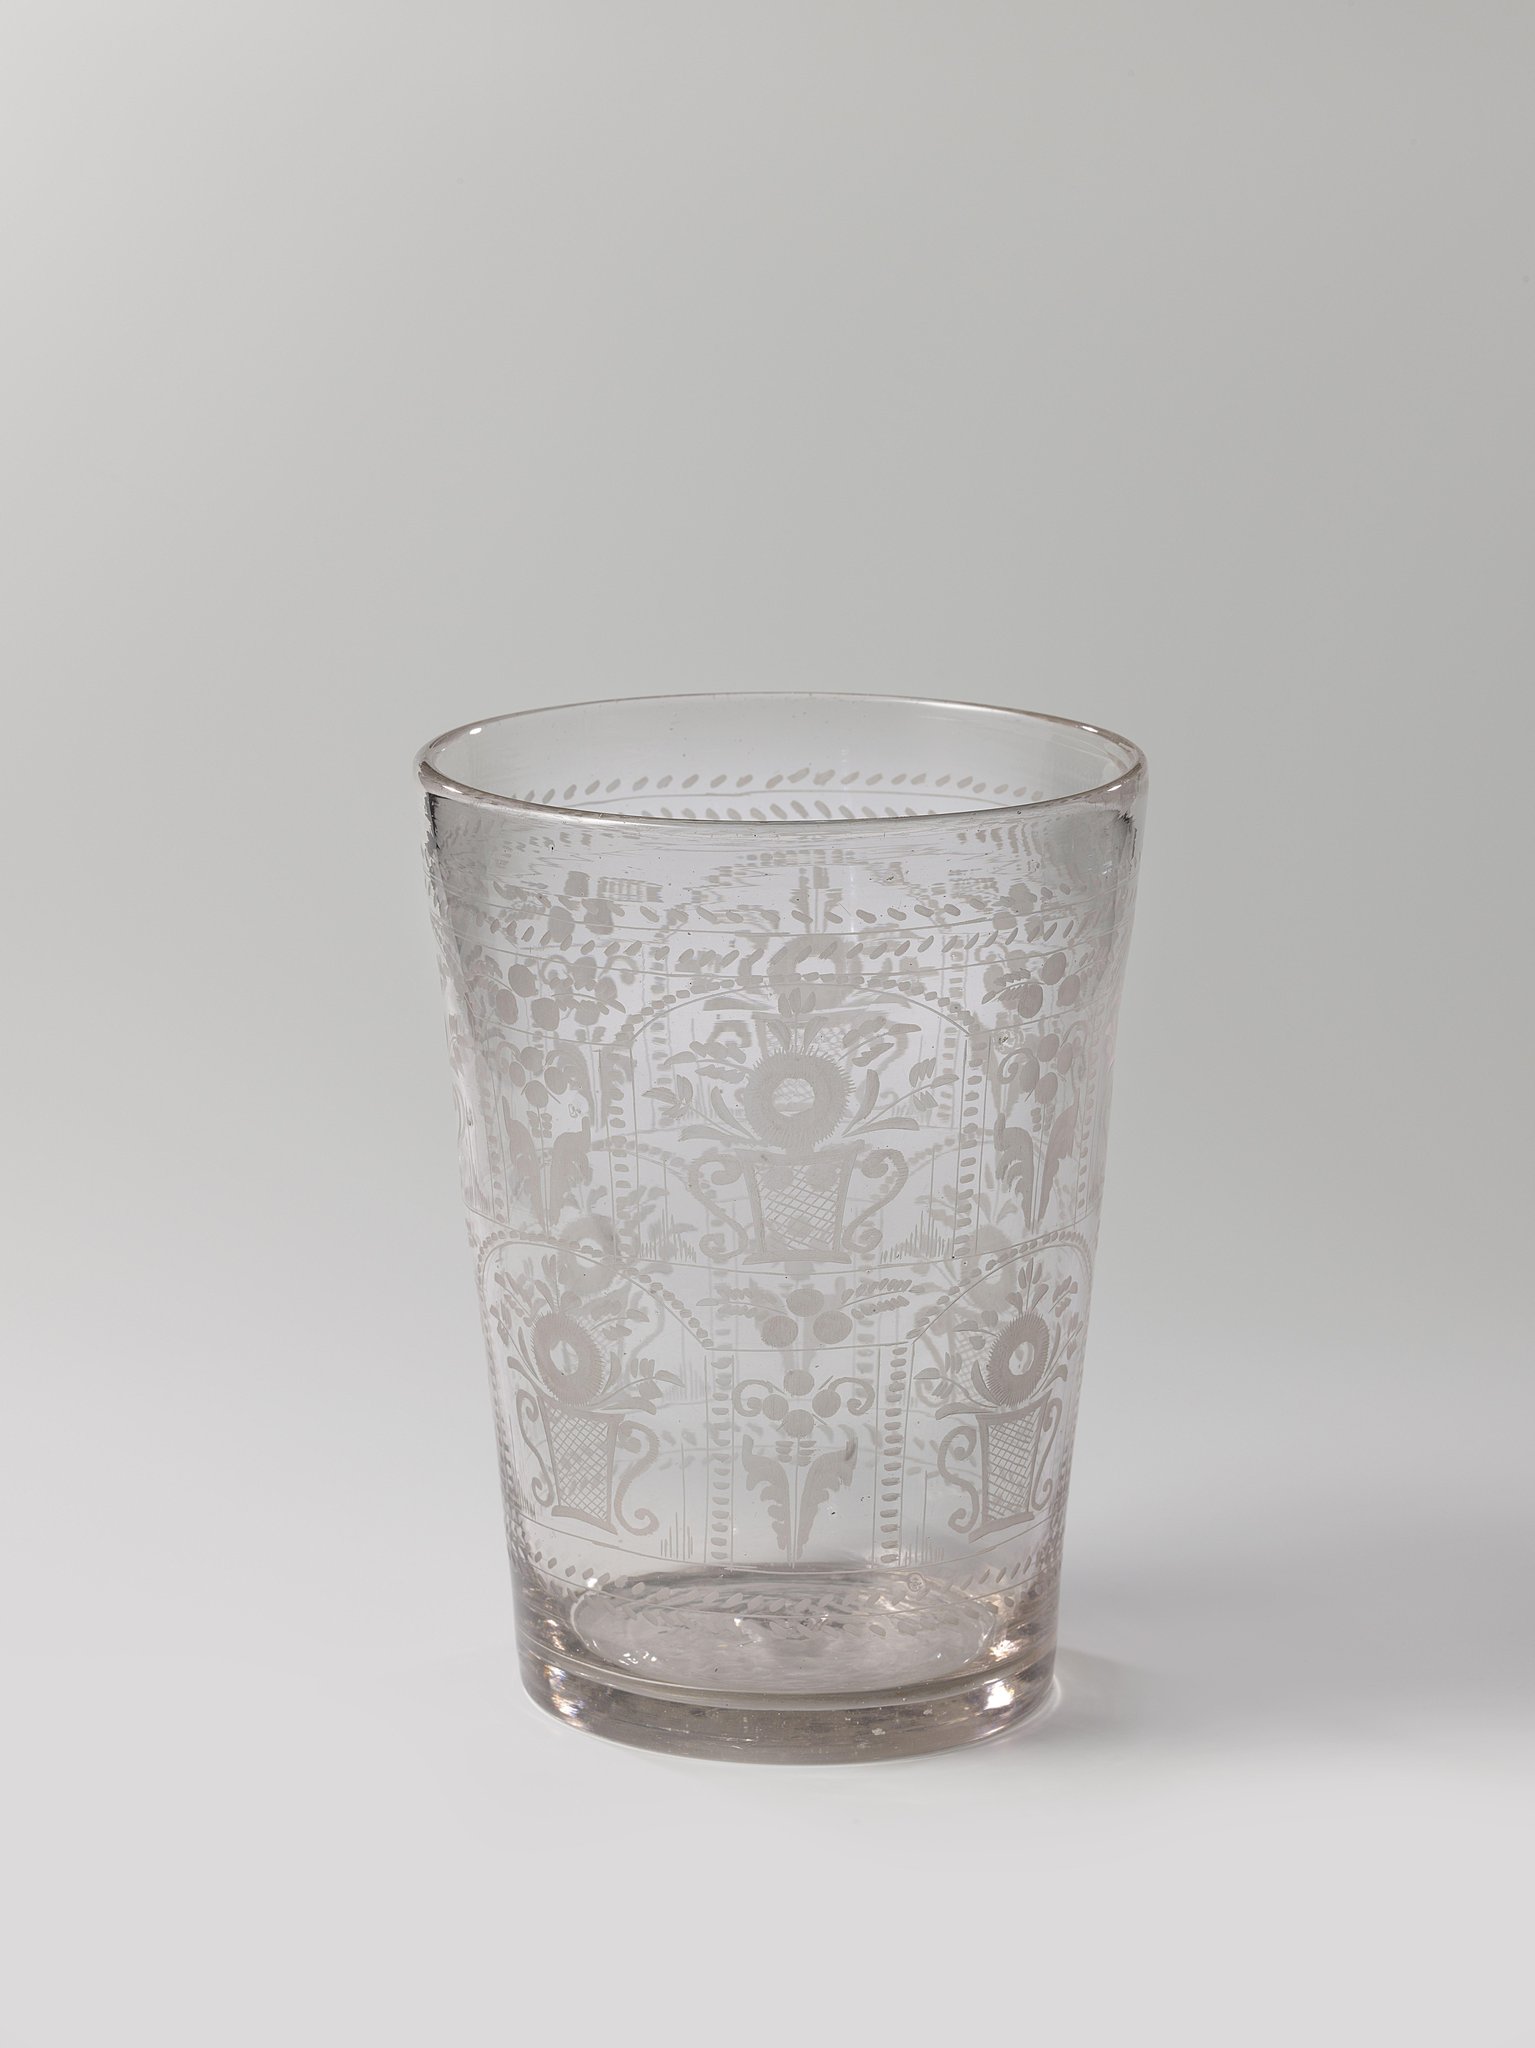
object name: cup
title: Beker met bloemenmanden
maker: Anonymous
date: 1700-1800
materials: glass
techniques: glassblowing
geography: bohemia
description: Beker van helder, kleurloos glas. Op de kelk gegraveerde bloemenmanden in nissen.